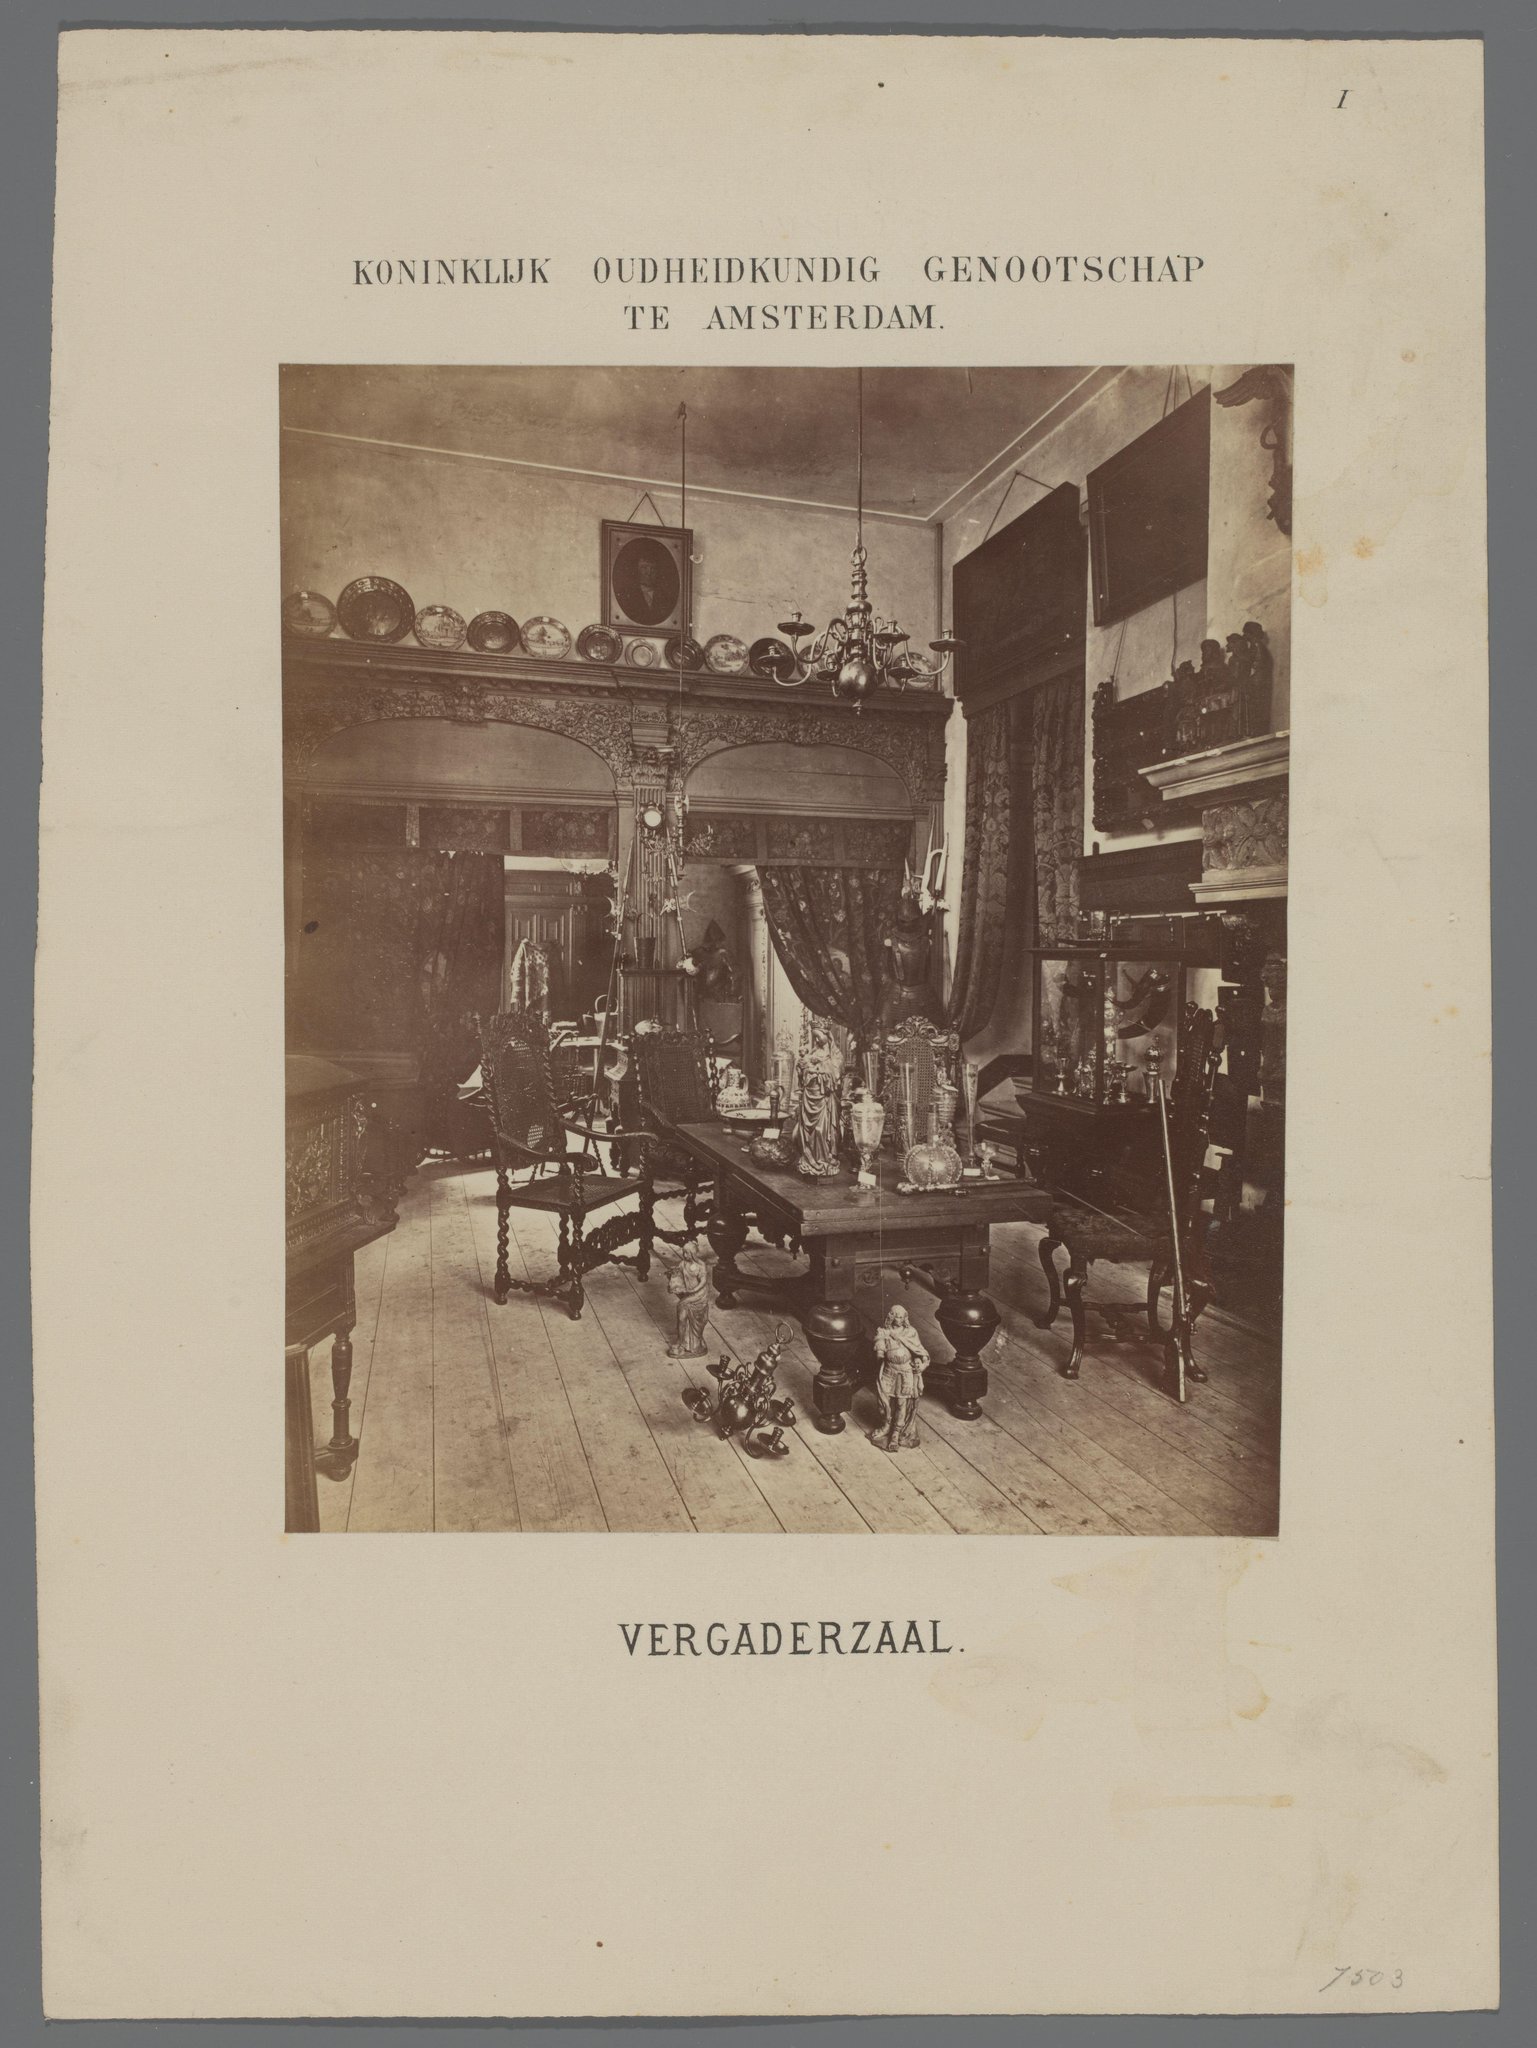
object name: photograph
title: Interieur van de 'vergaderzaal' van het Koninklijk Oudheidkundig Genootschap in de Spuistraat te Amsterdam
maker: pieter oosterhuis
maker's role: draughtsman, print maker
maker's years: 1816-1885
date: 1877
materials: cardboard, paper, photographic support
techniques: albumen print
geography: amsterdam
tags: assembly-room, amsterdam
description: Interieur van de vergaderzaal van het Museum van het Koninklijk Oudheidkundig Genootschap, Spuistraat, Amsterdam, geopend in 1877.